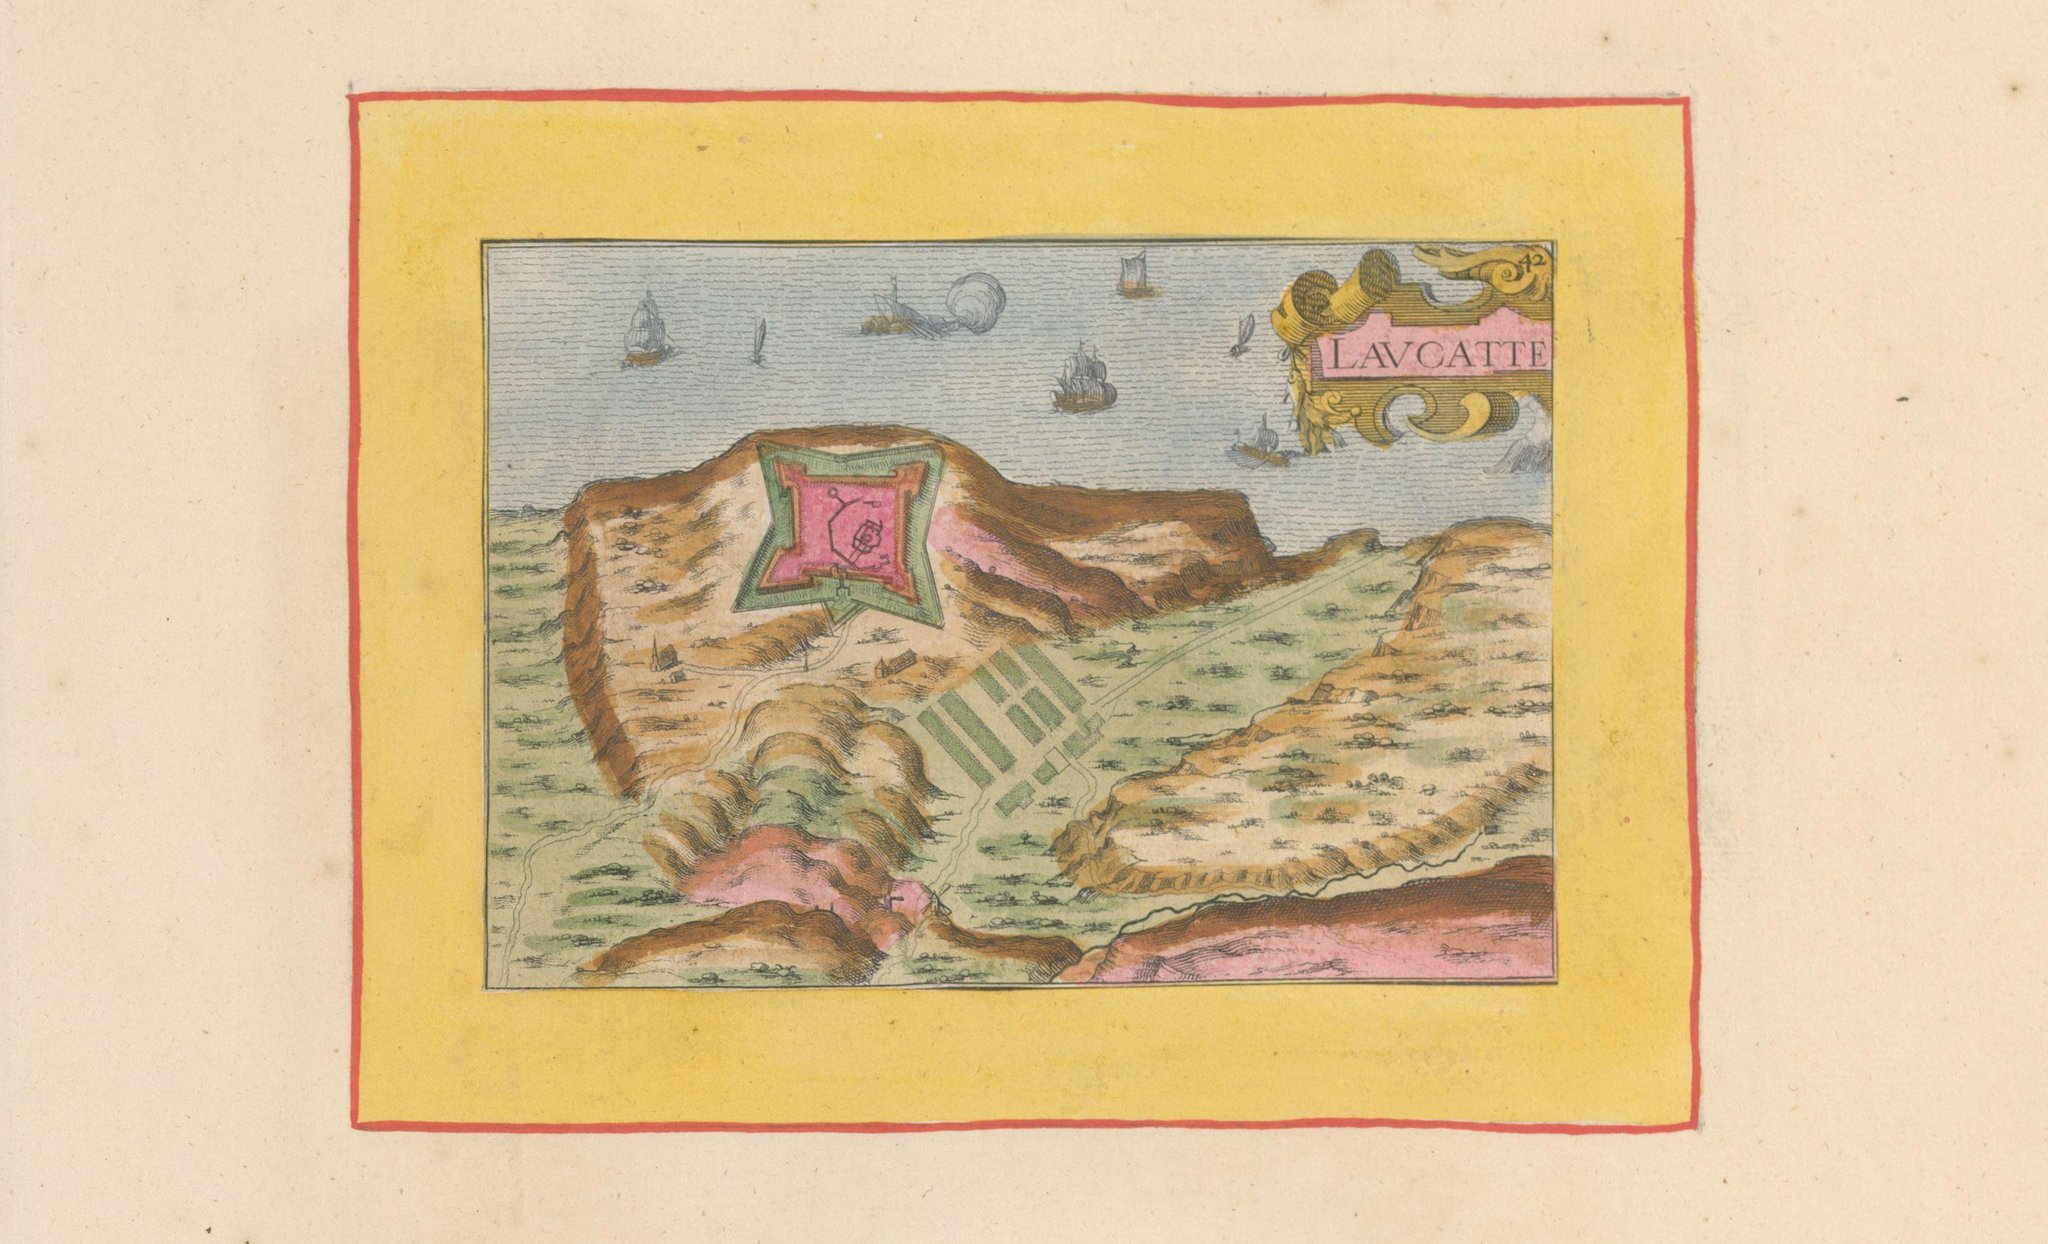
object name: area plan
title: Plattegrond van Leucate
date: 1638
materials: paper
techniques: engraving, etching, hand coloring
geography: paris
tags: maps of cities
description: Prent uit: Tassin, Christophe. Les plans et profils de toutes les principales villes et lieux considérables de France (...). Parijs: Michel van Lochom, 1638, prent nummer 42 in het deel 'Languedoc'.